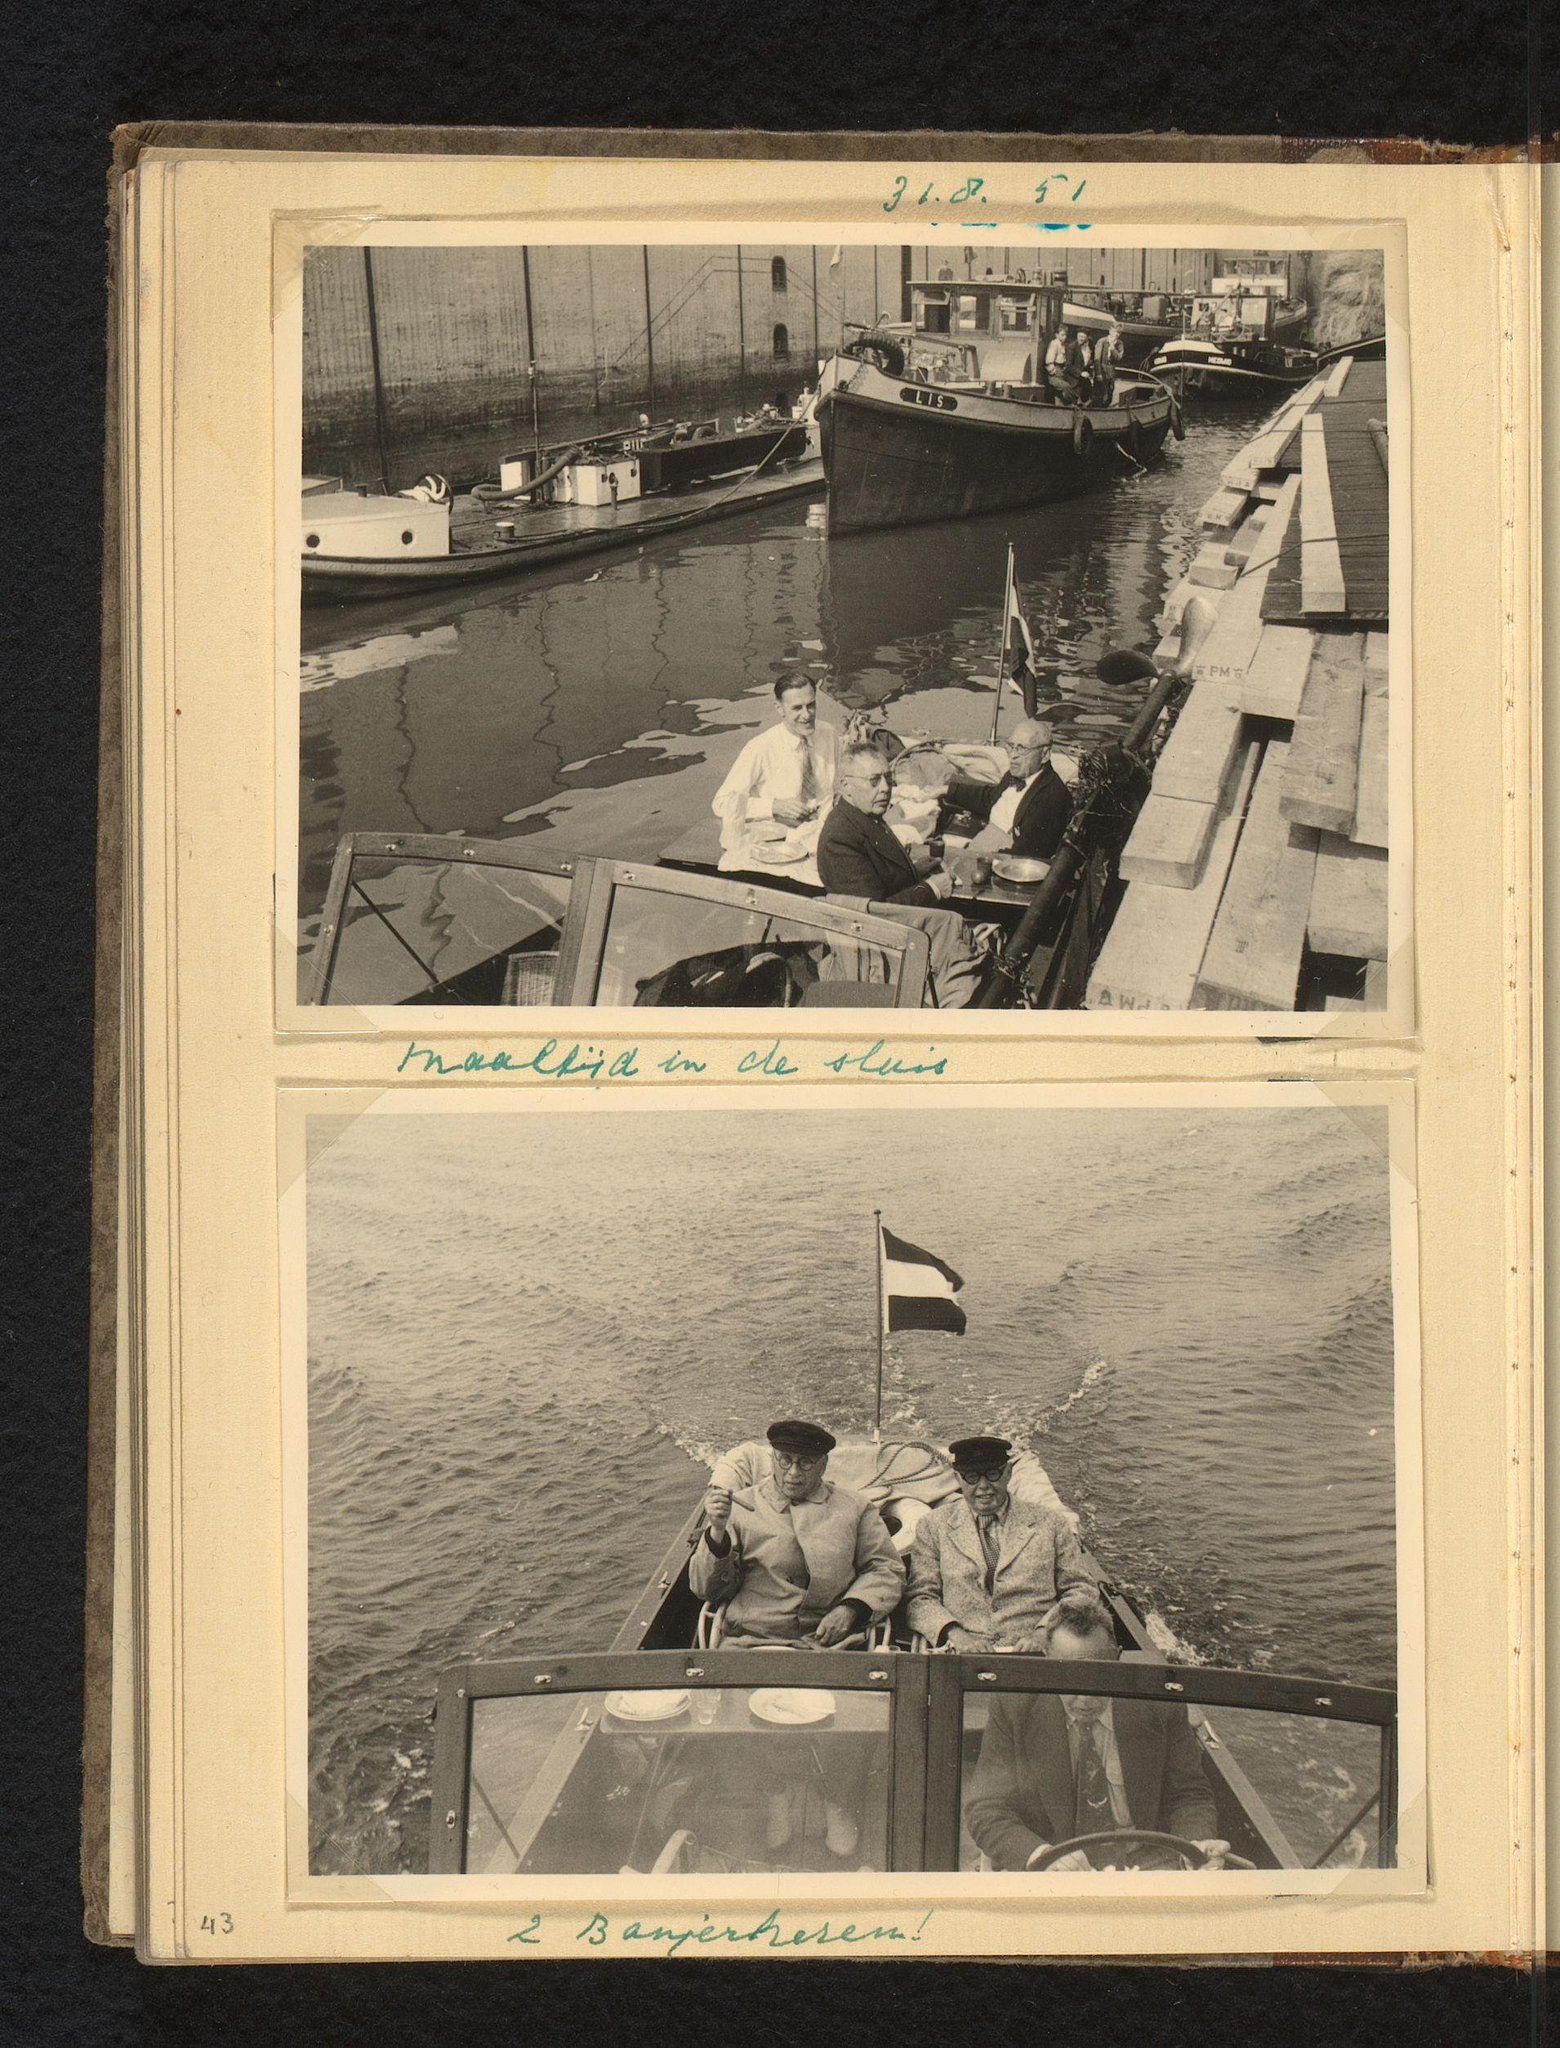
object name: album leaf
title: Twee foto's van een boottocht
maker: Anonymous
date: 1951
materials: paper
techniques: gelatin silver print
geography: netherlands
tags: rotterdam, dirk hudig (1876-1973), sluice, weir, steamship, motorship, netherlands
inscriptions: inscription: ‘Maaltijd in de sluis’, inscription: ‘2 Banjerheren!’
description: Deze foto's maken deel uit van een album.